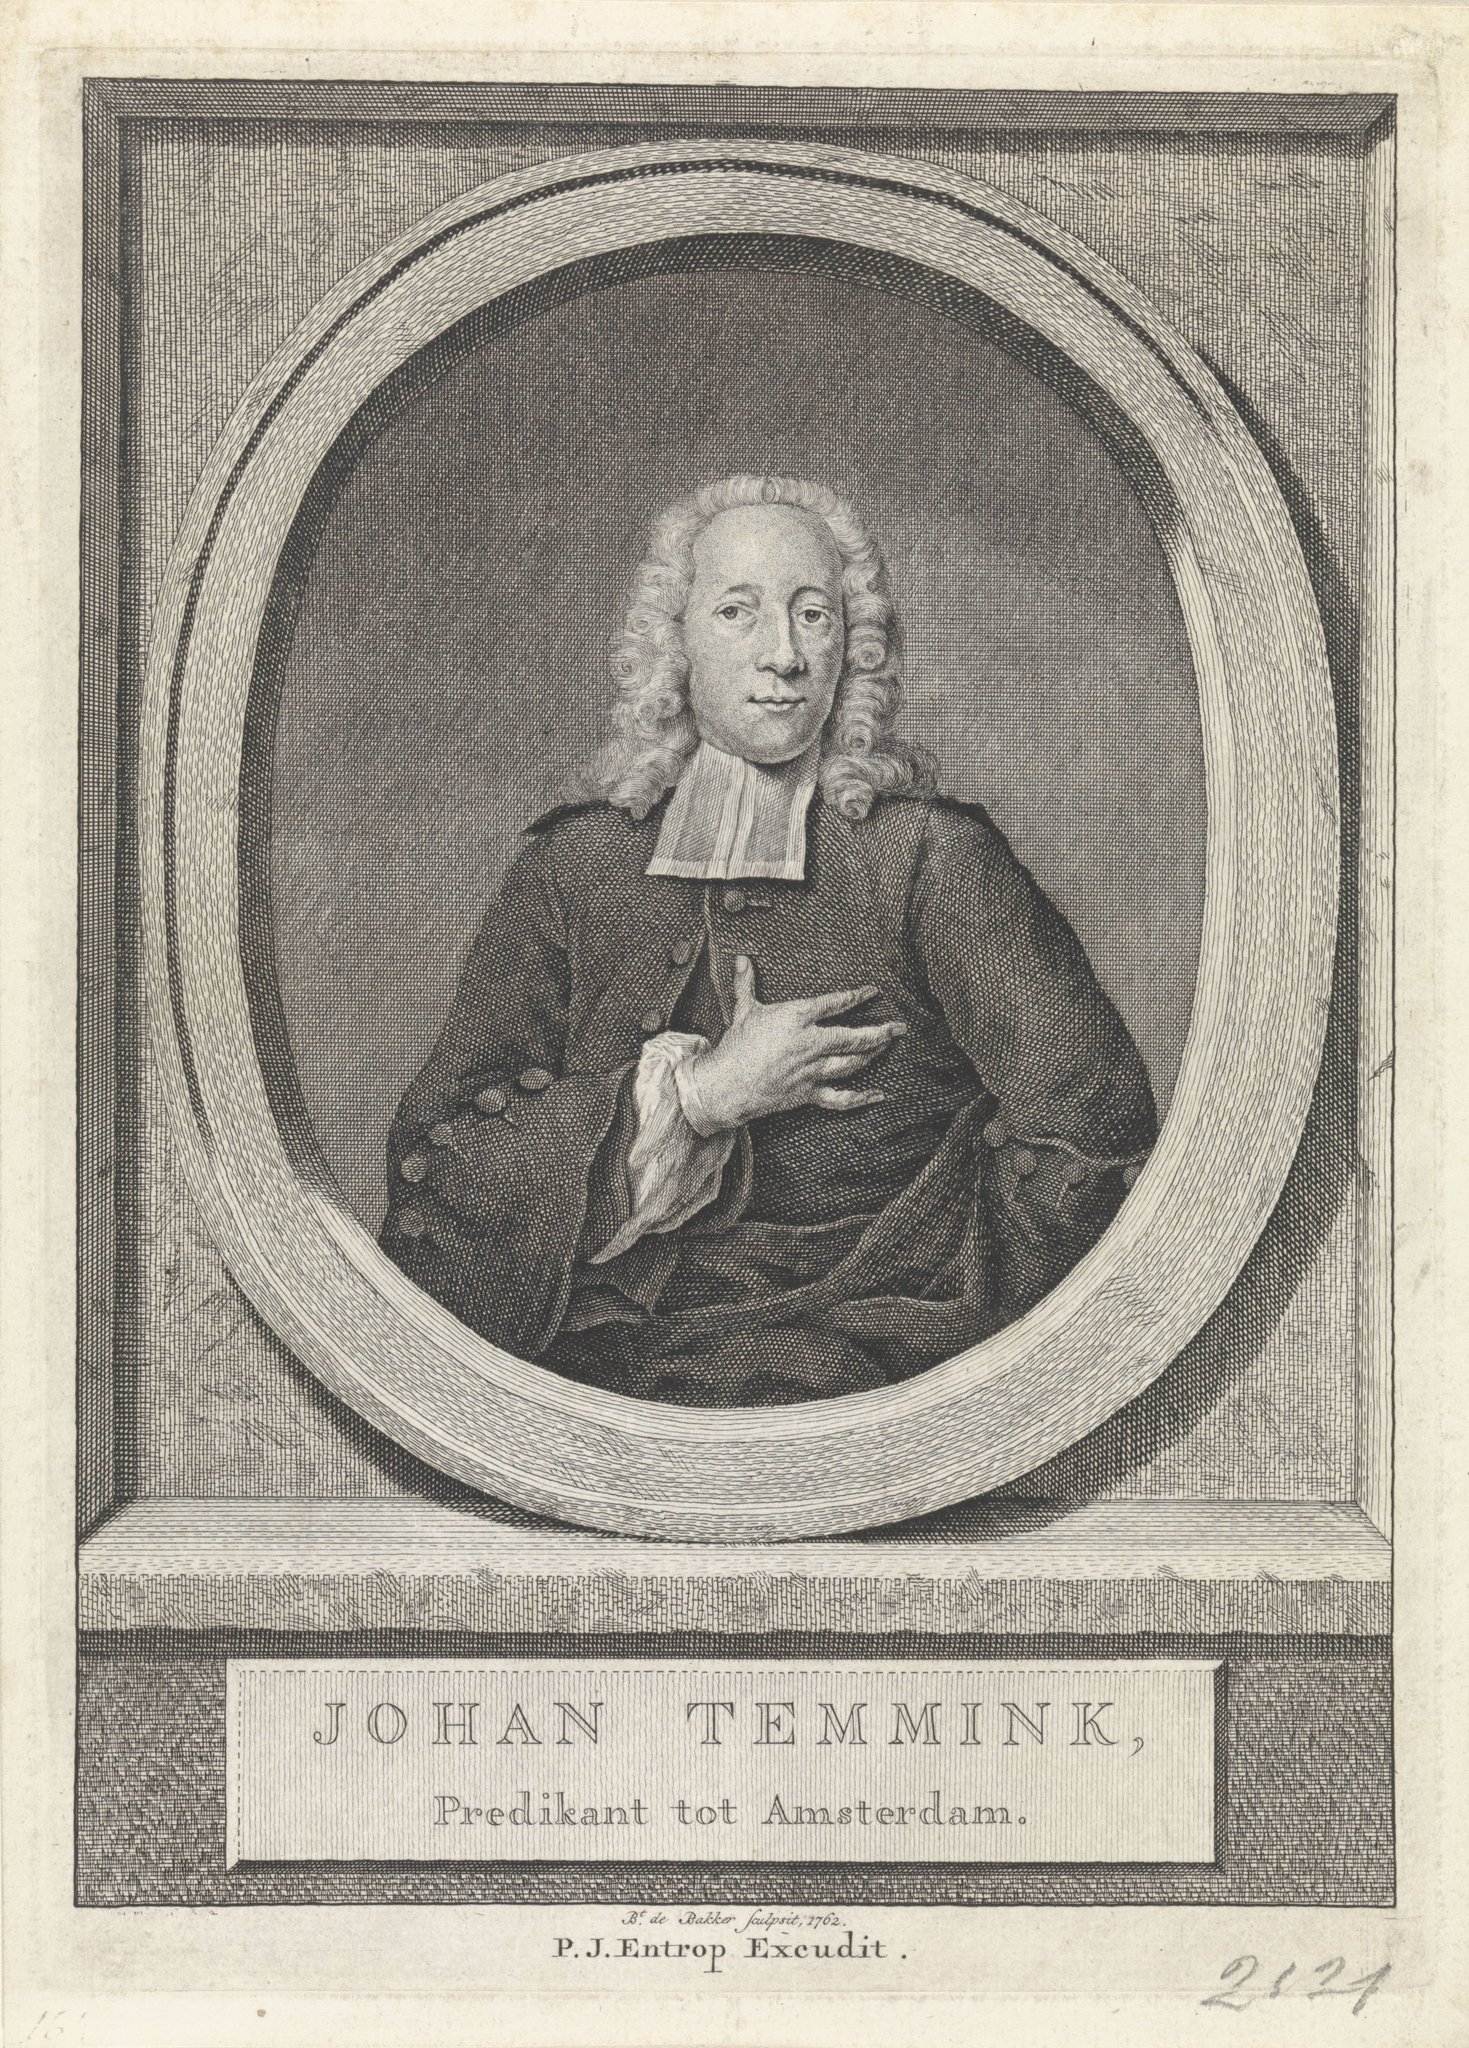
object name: print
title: Johan Temmink predikant tot Amsterdam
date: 1762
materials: paper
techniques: engraving, etching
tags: functionaries and dignitaries (with name) ~ episcopal protestant churches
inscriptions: date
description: Vergelijk prent met vergelijkbaar portret in collectie Stadsarchief Amsterdam door C.F. Fritsch naar tekening van Jacob van der Schley. Mogelijk maakte Barent de Bakker gebruik van dezelfde tekening.